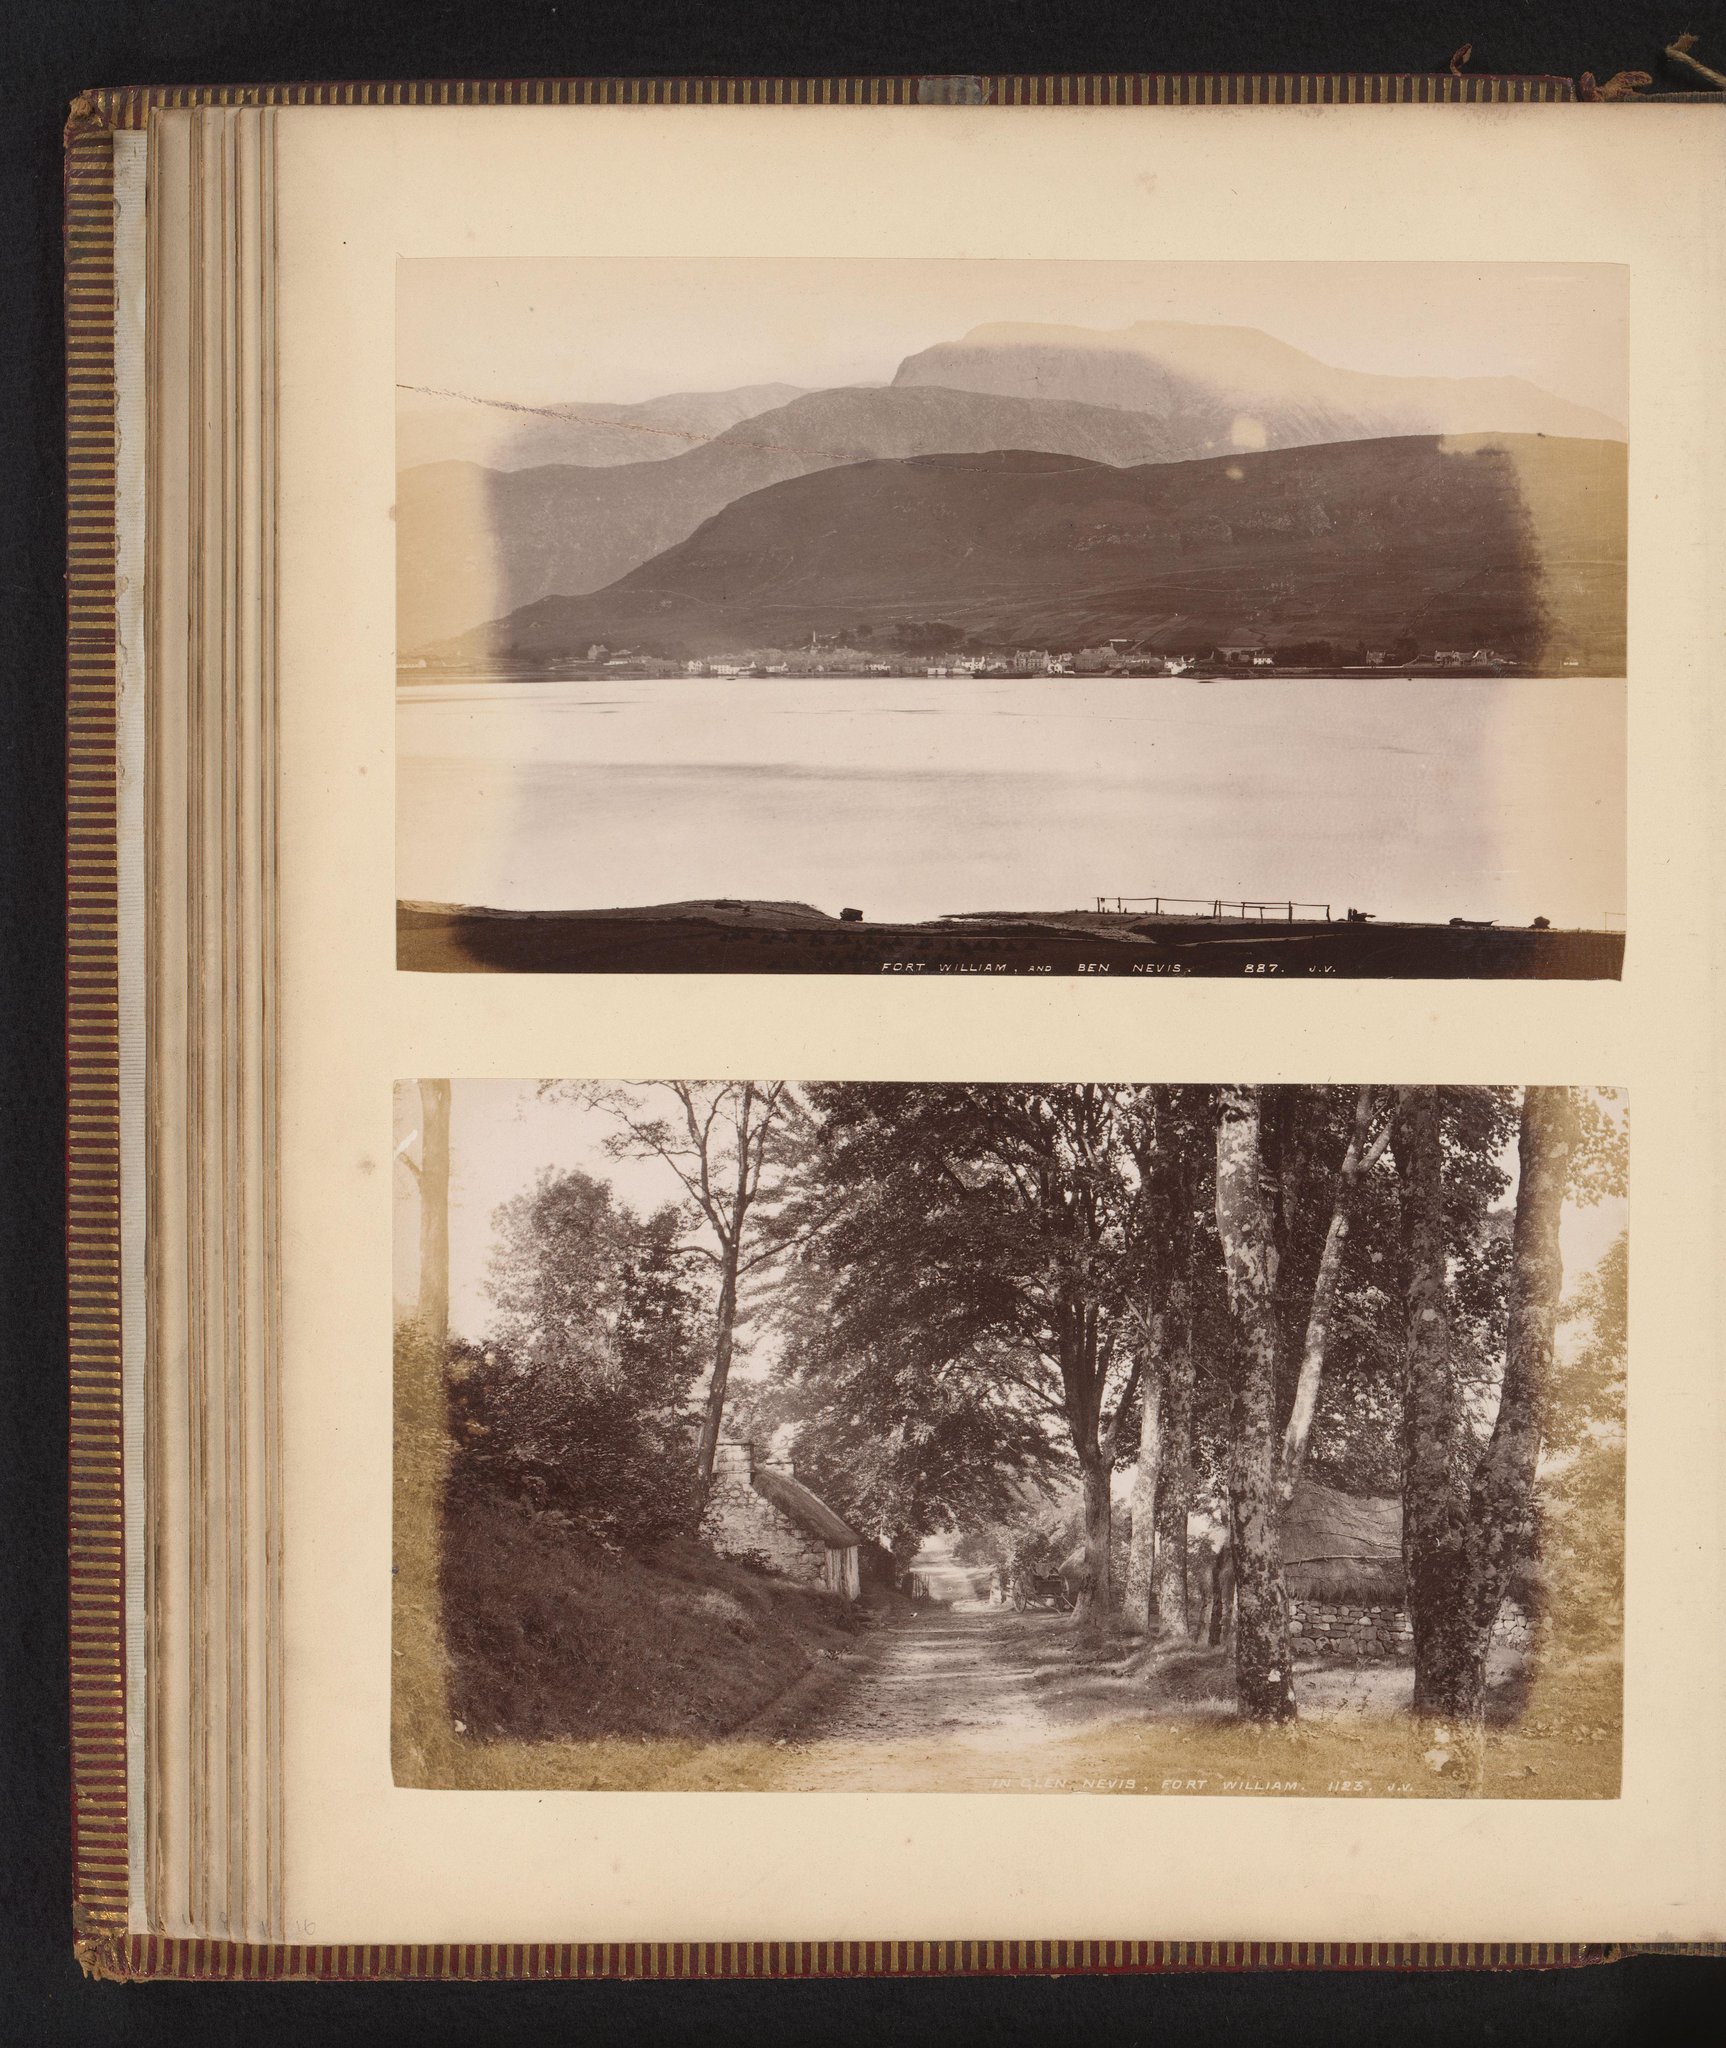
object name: album leaf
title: Gezicht op Fort William en Ben Nevis en Pad bij Glen Nevis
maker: Anonymous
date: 1875-1885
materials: photographic support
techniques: albumen print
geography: inverness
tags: landscapes with waters, waterscapes, seascapes (in the temperate zone), road, path, mountains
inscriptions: number: ‘1123, J.V.’, number: ‘887, J.V.’